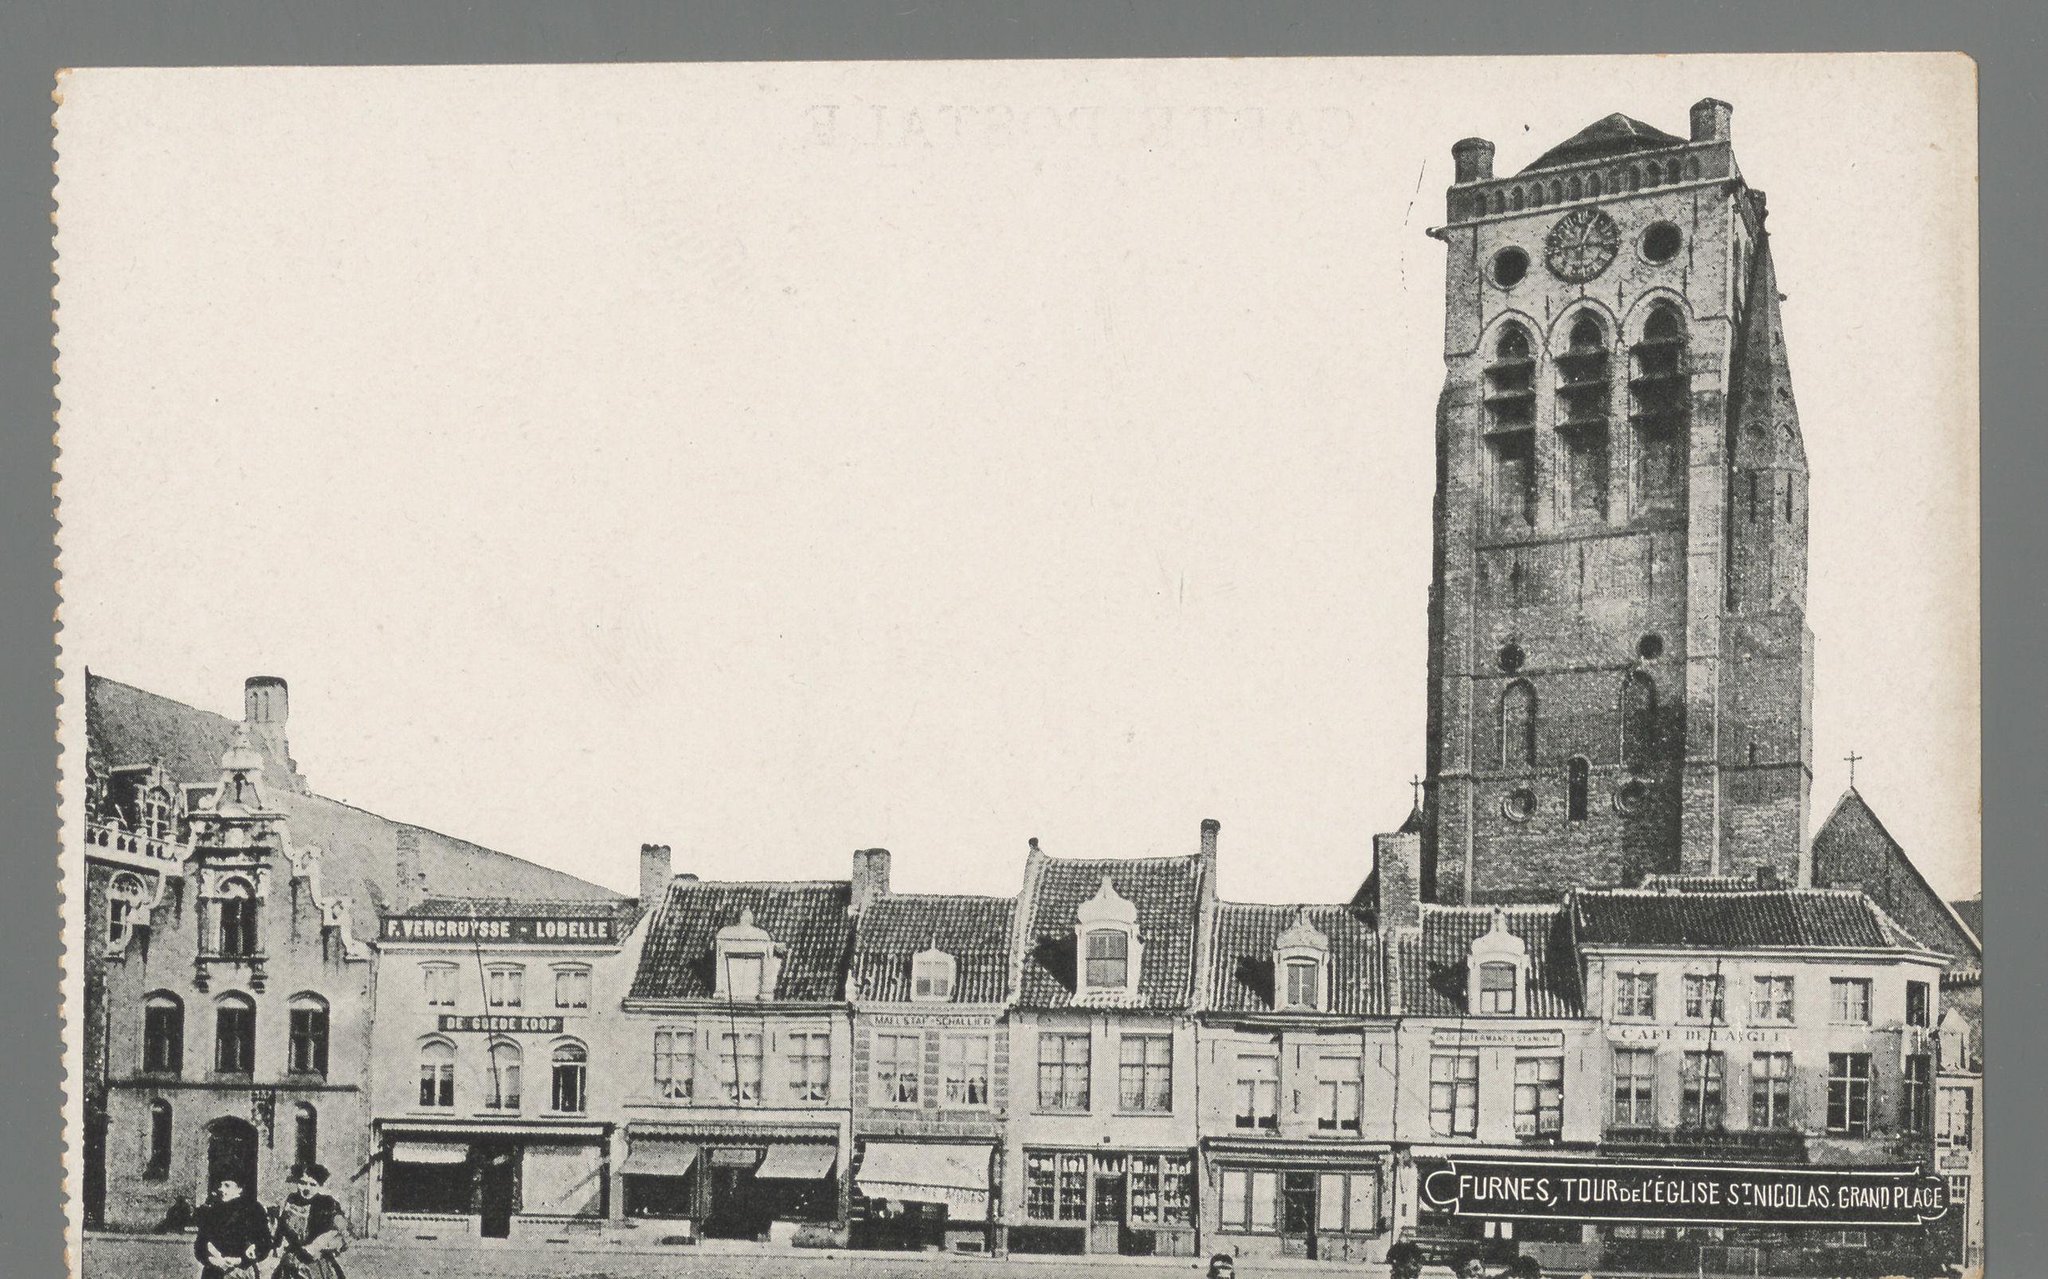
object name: photomechanical print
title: Furnes, tour de l'église St. Nicolas, Grand Place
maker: Anonymous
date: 1906-1918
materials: cardboard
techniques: autotype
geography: veurne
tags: square, place, circus, etc., roman catholic church